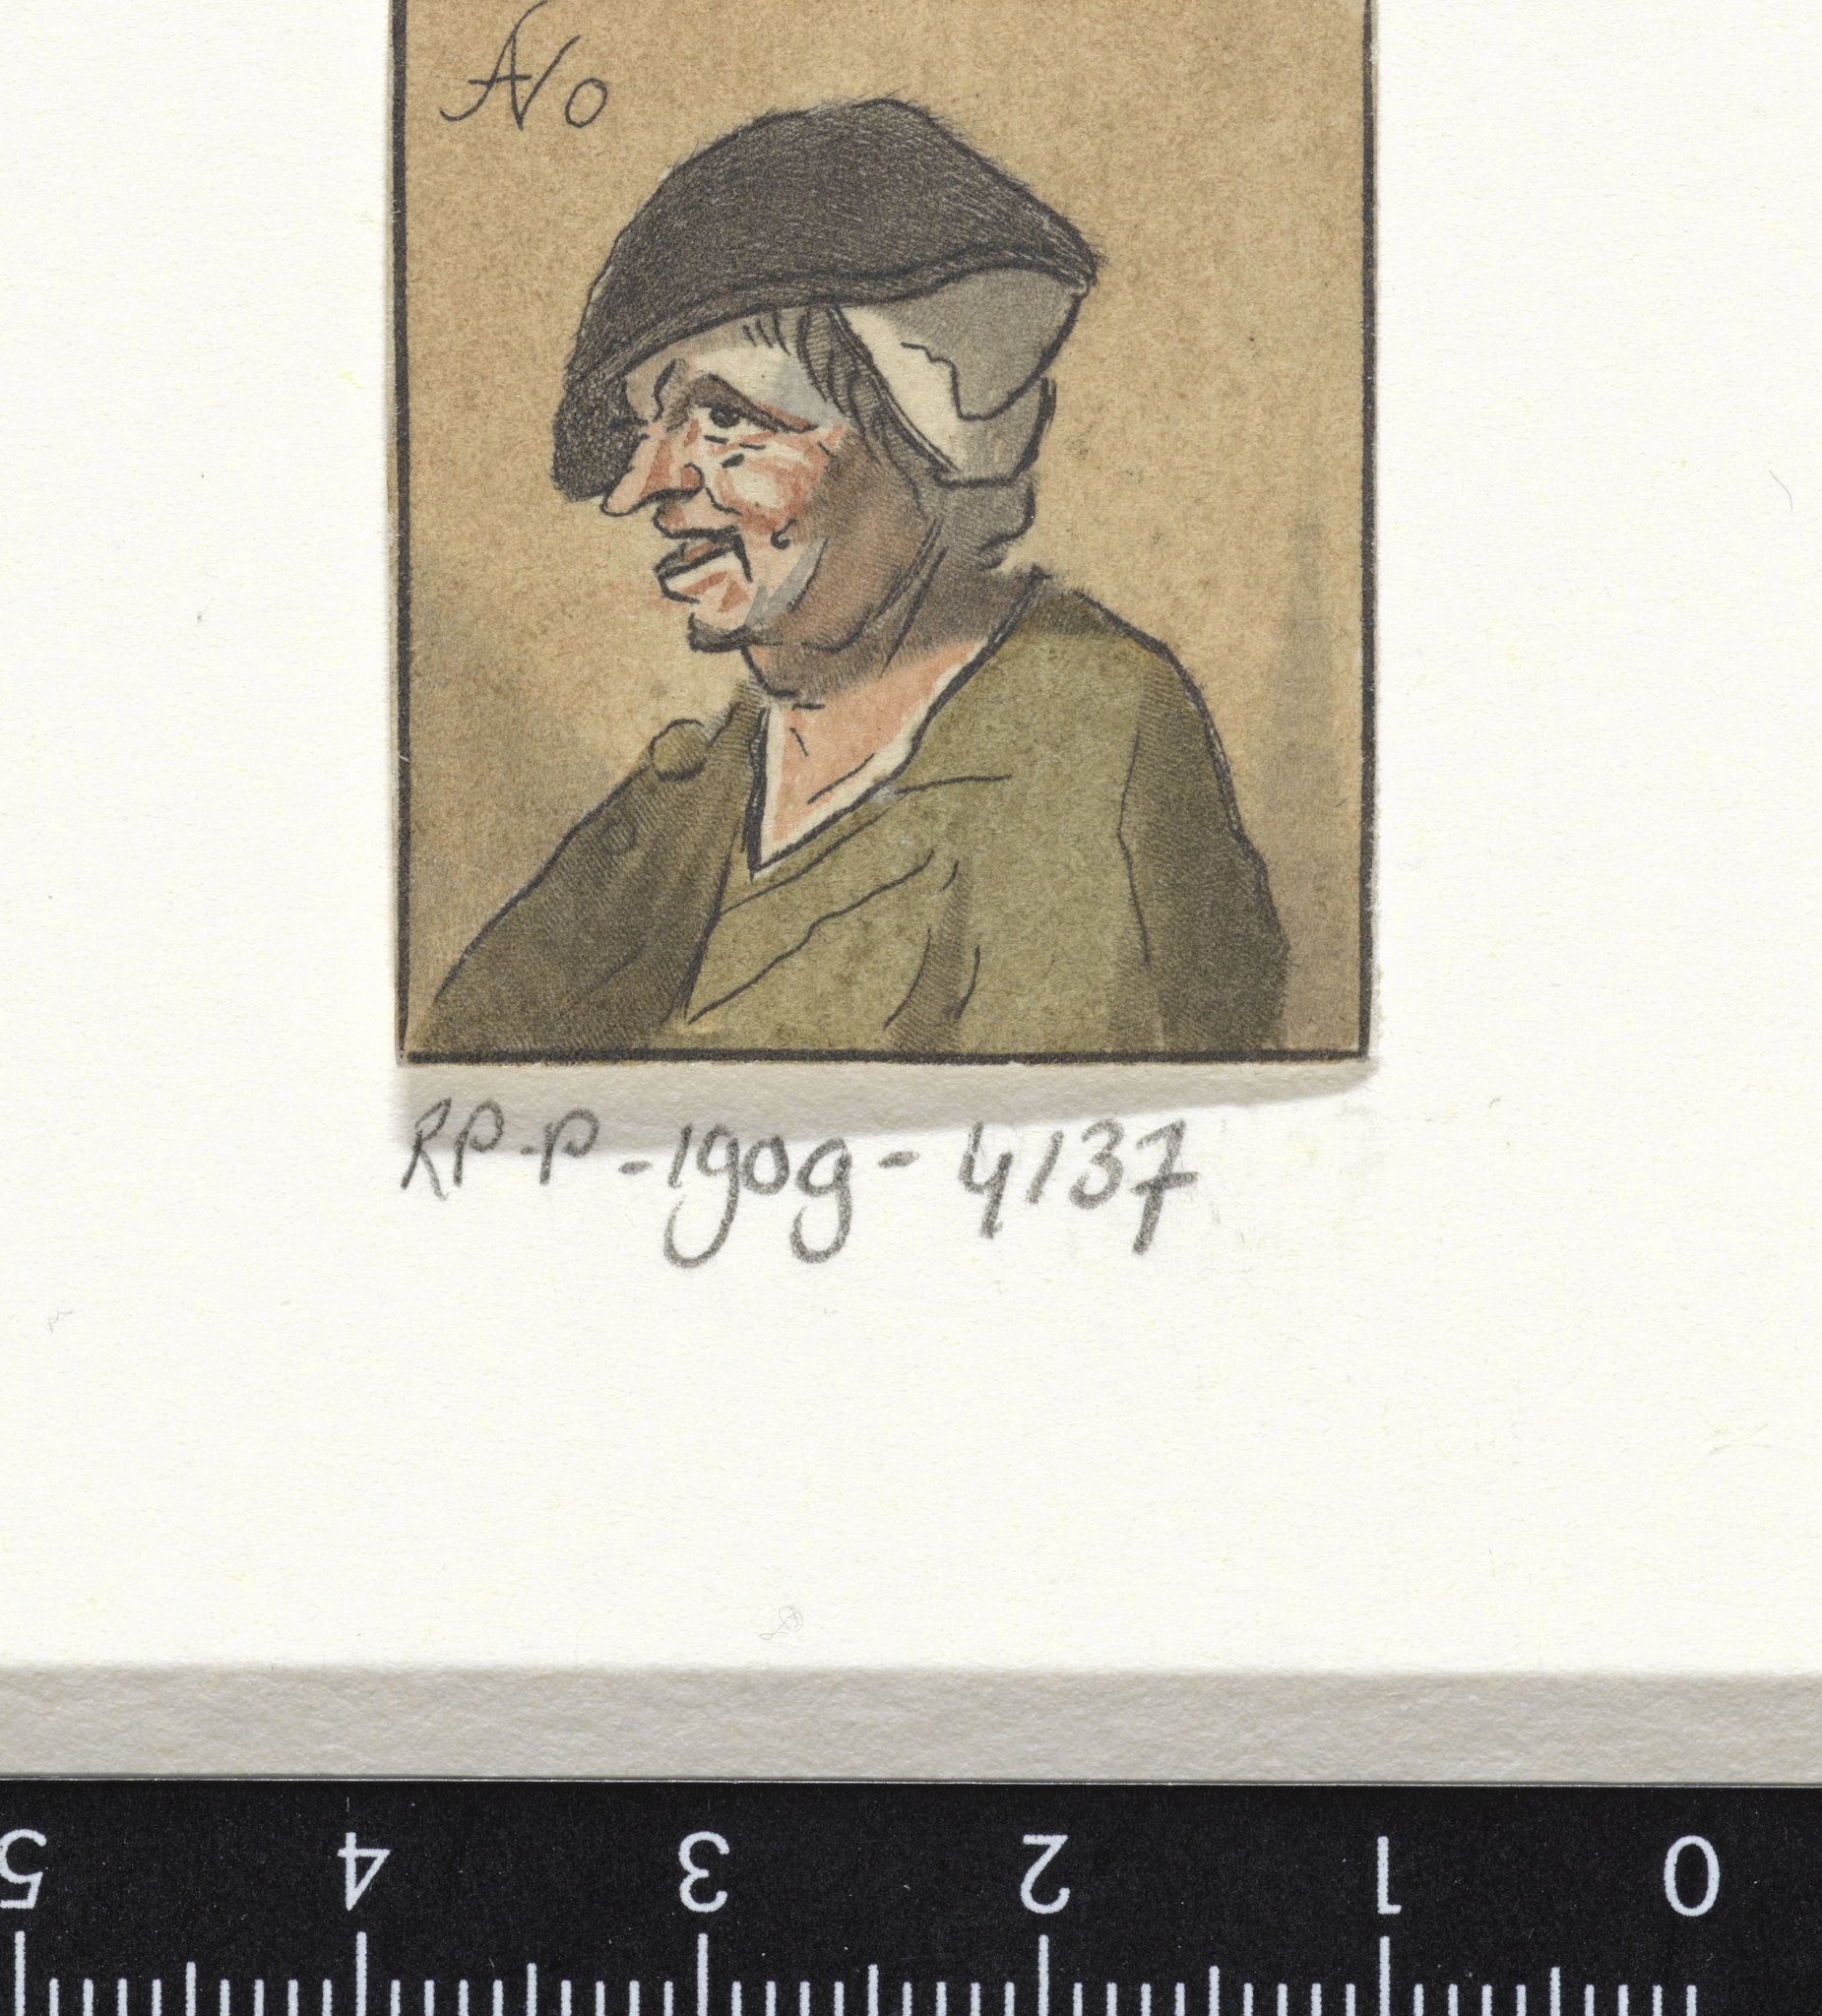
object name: print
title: Portret van een boer in profiel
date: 1767-1780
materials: paper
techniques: etching, rocker stamped, lithography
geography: amsterdam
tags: head-gear: cap (+ men's clothes)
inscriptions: collector's mark: Lugt 2228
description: Prent uit: Het werk van den alöm beroemde konstschilder Adriaan van Ostade, volgens de mannier als teekeningen in het koper gebragt, en met alle zyn kleuren gedrukt, door het Overyssels konstgenootschap, onder de zinspreuk Artium Tristis Janua. Amsterdam: Frederik Willem Greebe, [voor 1780].